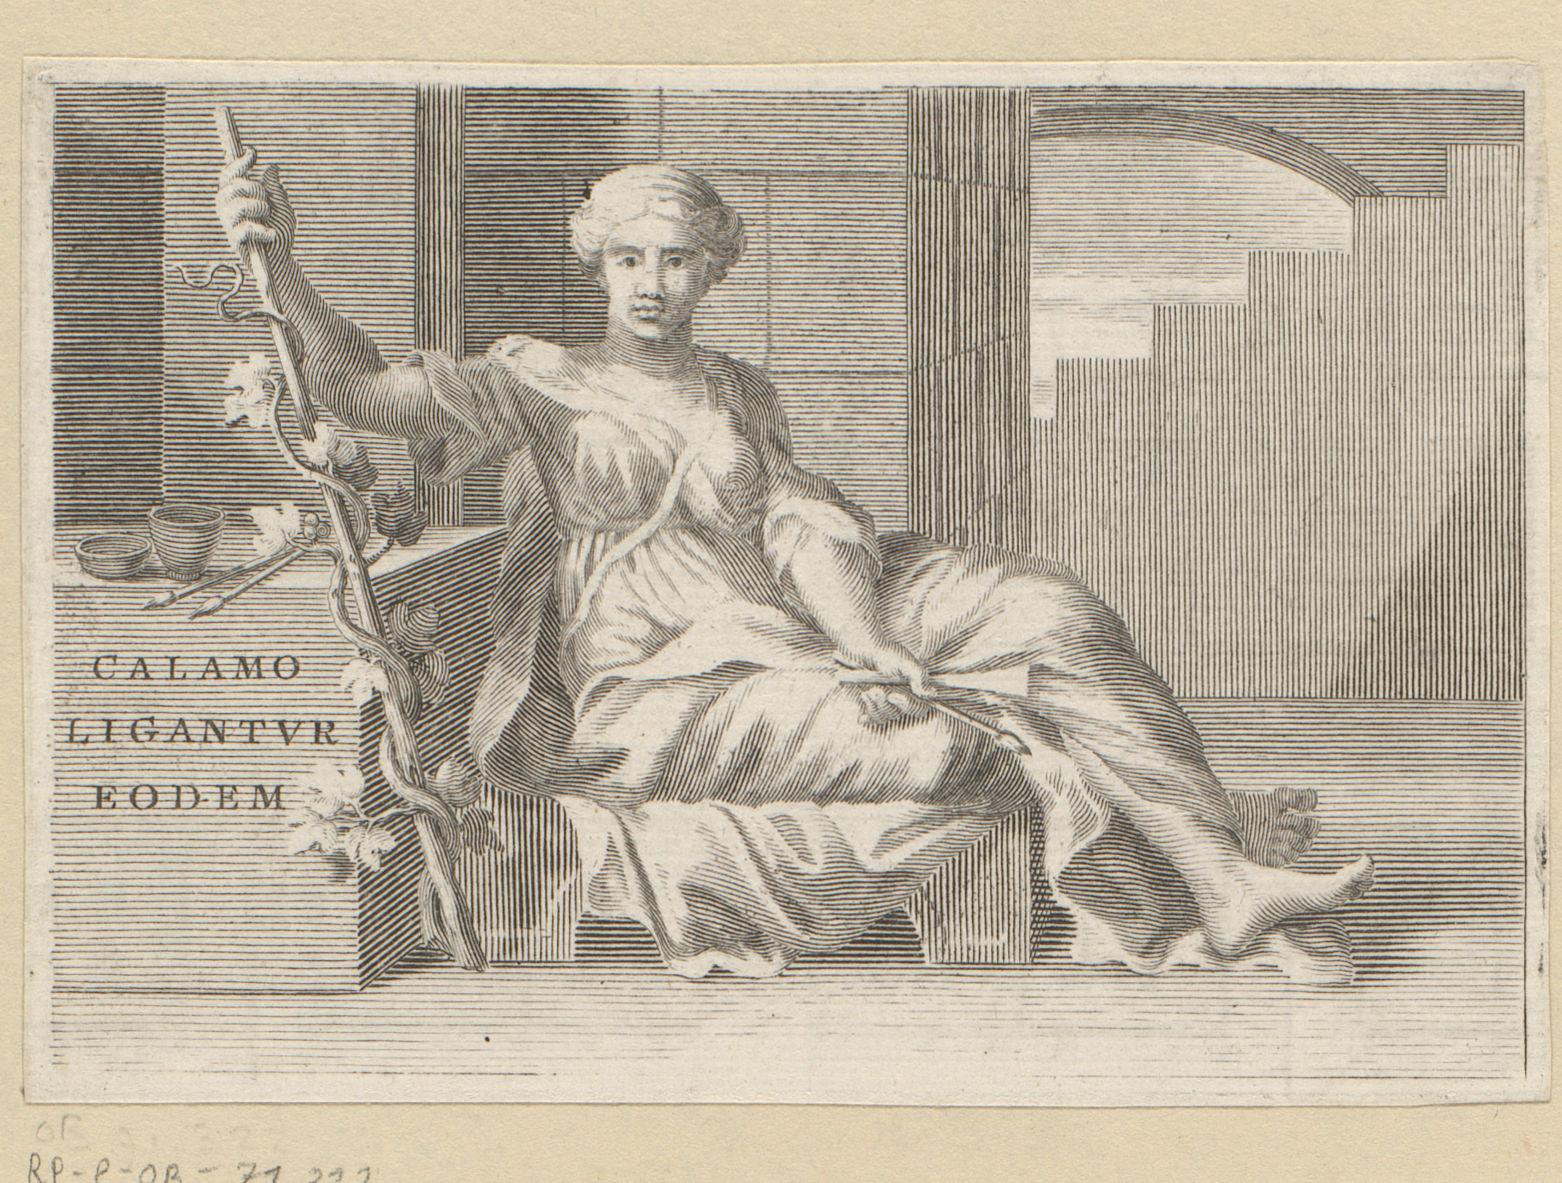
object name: print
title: Zittende vrouw met wijnrank en penselen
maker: claude mellan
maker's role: draughtsman, print maker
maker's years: 1598-1688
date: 1608-1688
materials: paper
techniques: engraving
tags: sitting figure - aa - female human figure, brushes ~ implements of painter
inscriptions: collector's mark: Lugt 240